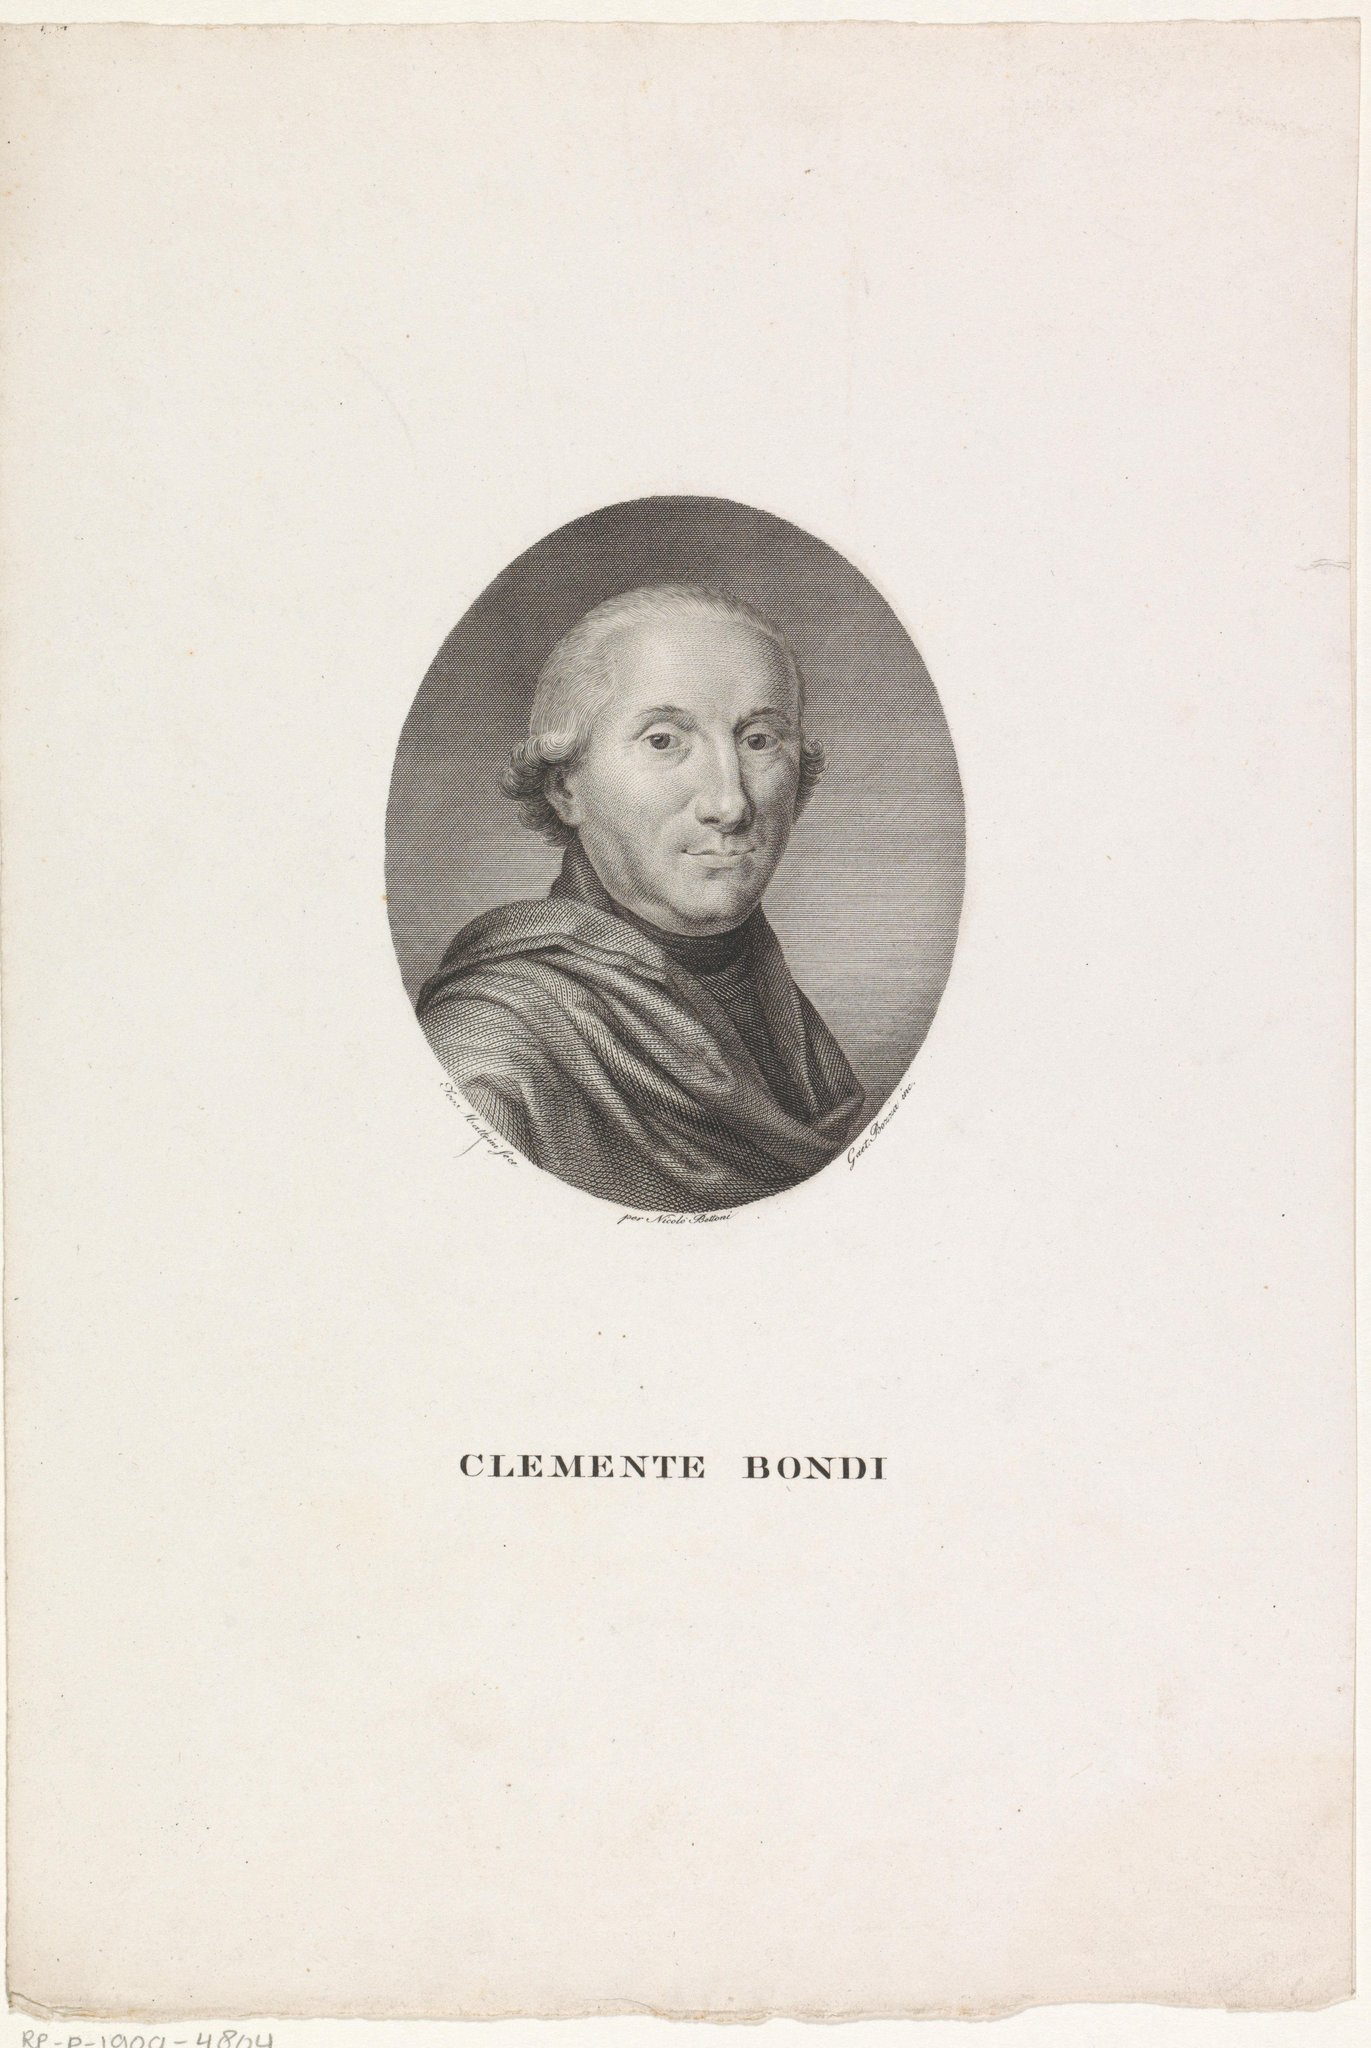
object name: print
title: Portretten van beroemde Italianen in ovalen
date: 1800-1899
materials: paper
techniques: engraving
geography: italy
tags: historical persons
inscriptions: collector's mark: Lugt 2228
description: Deze prent maakt deel uit van een reeks portretprenten van onbekende omvang. De reeks is in meerdere staten uitgegeven. De eerste staat met enkel het portret in ovaal. Een tweede staat met naam van de geportretteerde in holle letters onder de voorstelling. Een derde staat met de naam van de geportretteerde in gevulde letters onder de voorstelling. En een vierde staat met een rechthoekig kader rondom het ovale portret.